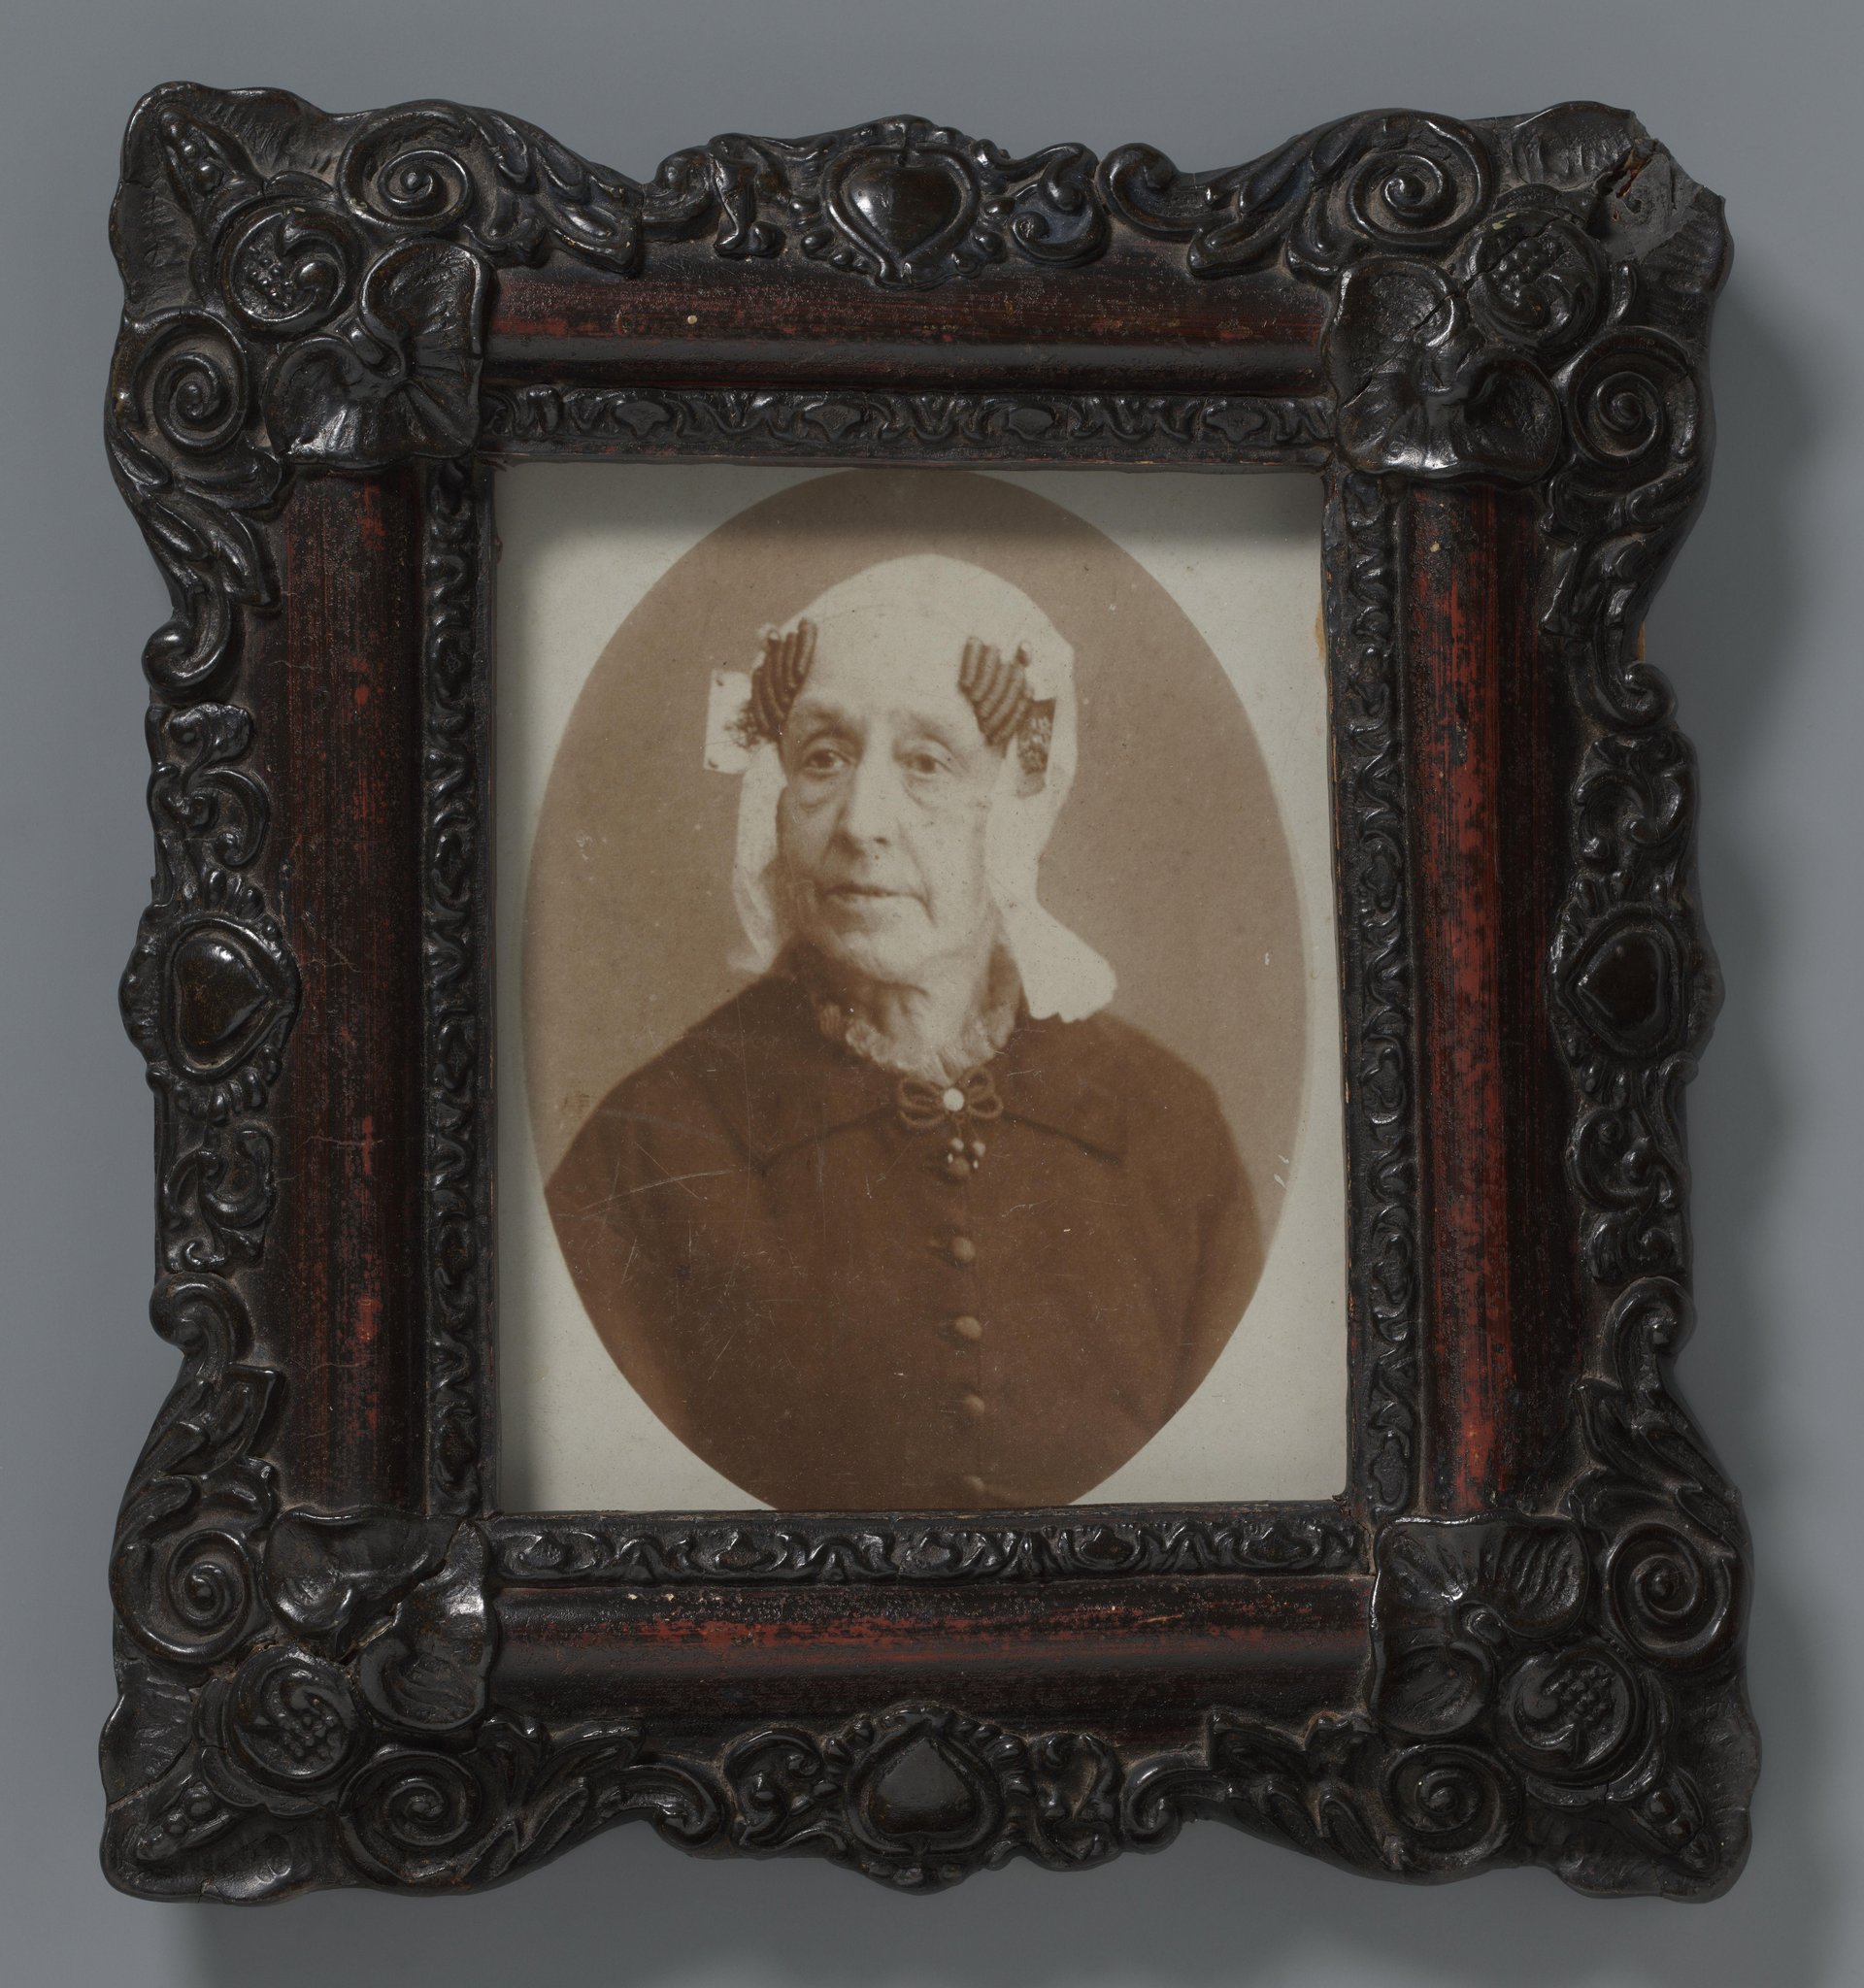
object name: frame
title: Portret van een onbekende oudere vrouw in klederdracht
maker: Anonymous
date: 1880-1900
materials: paper, cardboard, glass, metal, wood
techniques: gelatin silver print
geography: netherlands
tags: historical persons not known by name - bb - woman, folk costume, regional costume, netherlands